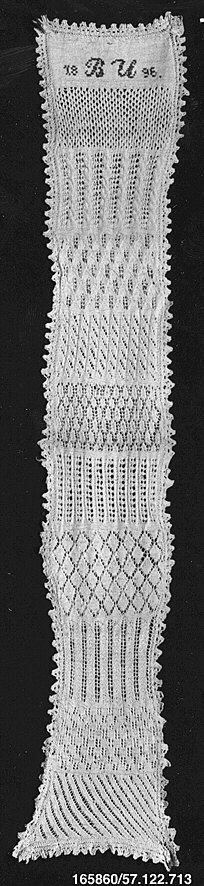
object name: sampler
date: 1801-1900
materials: lace, wool